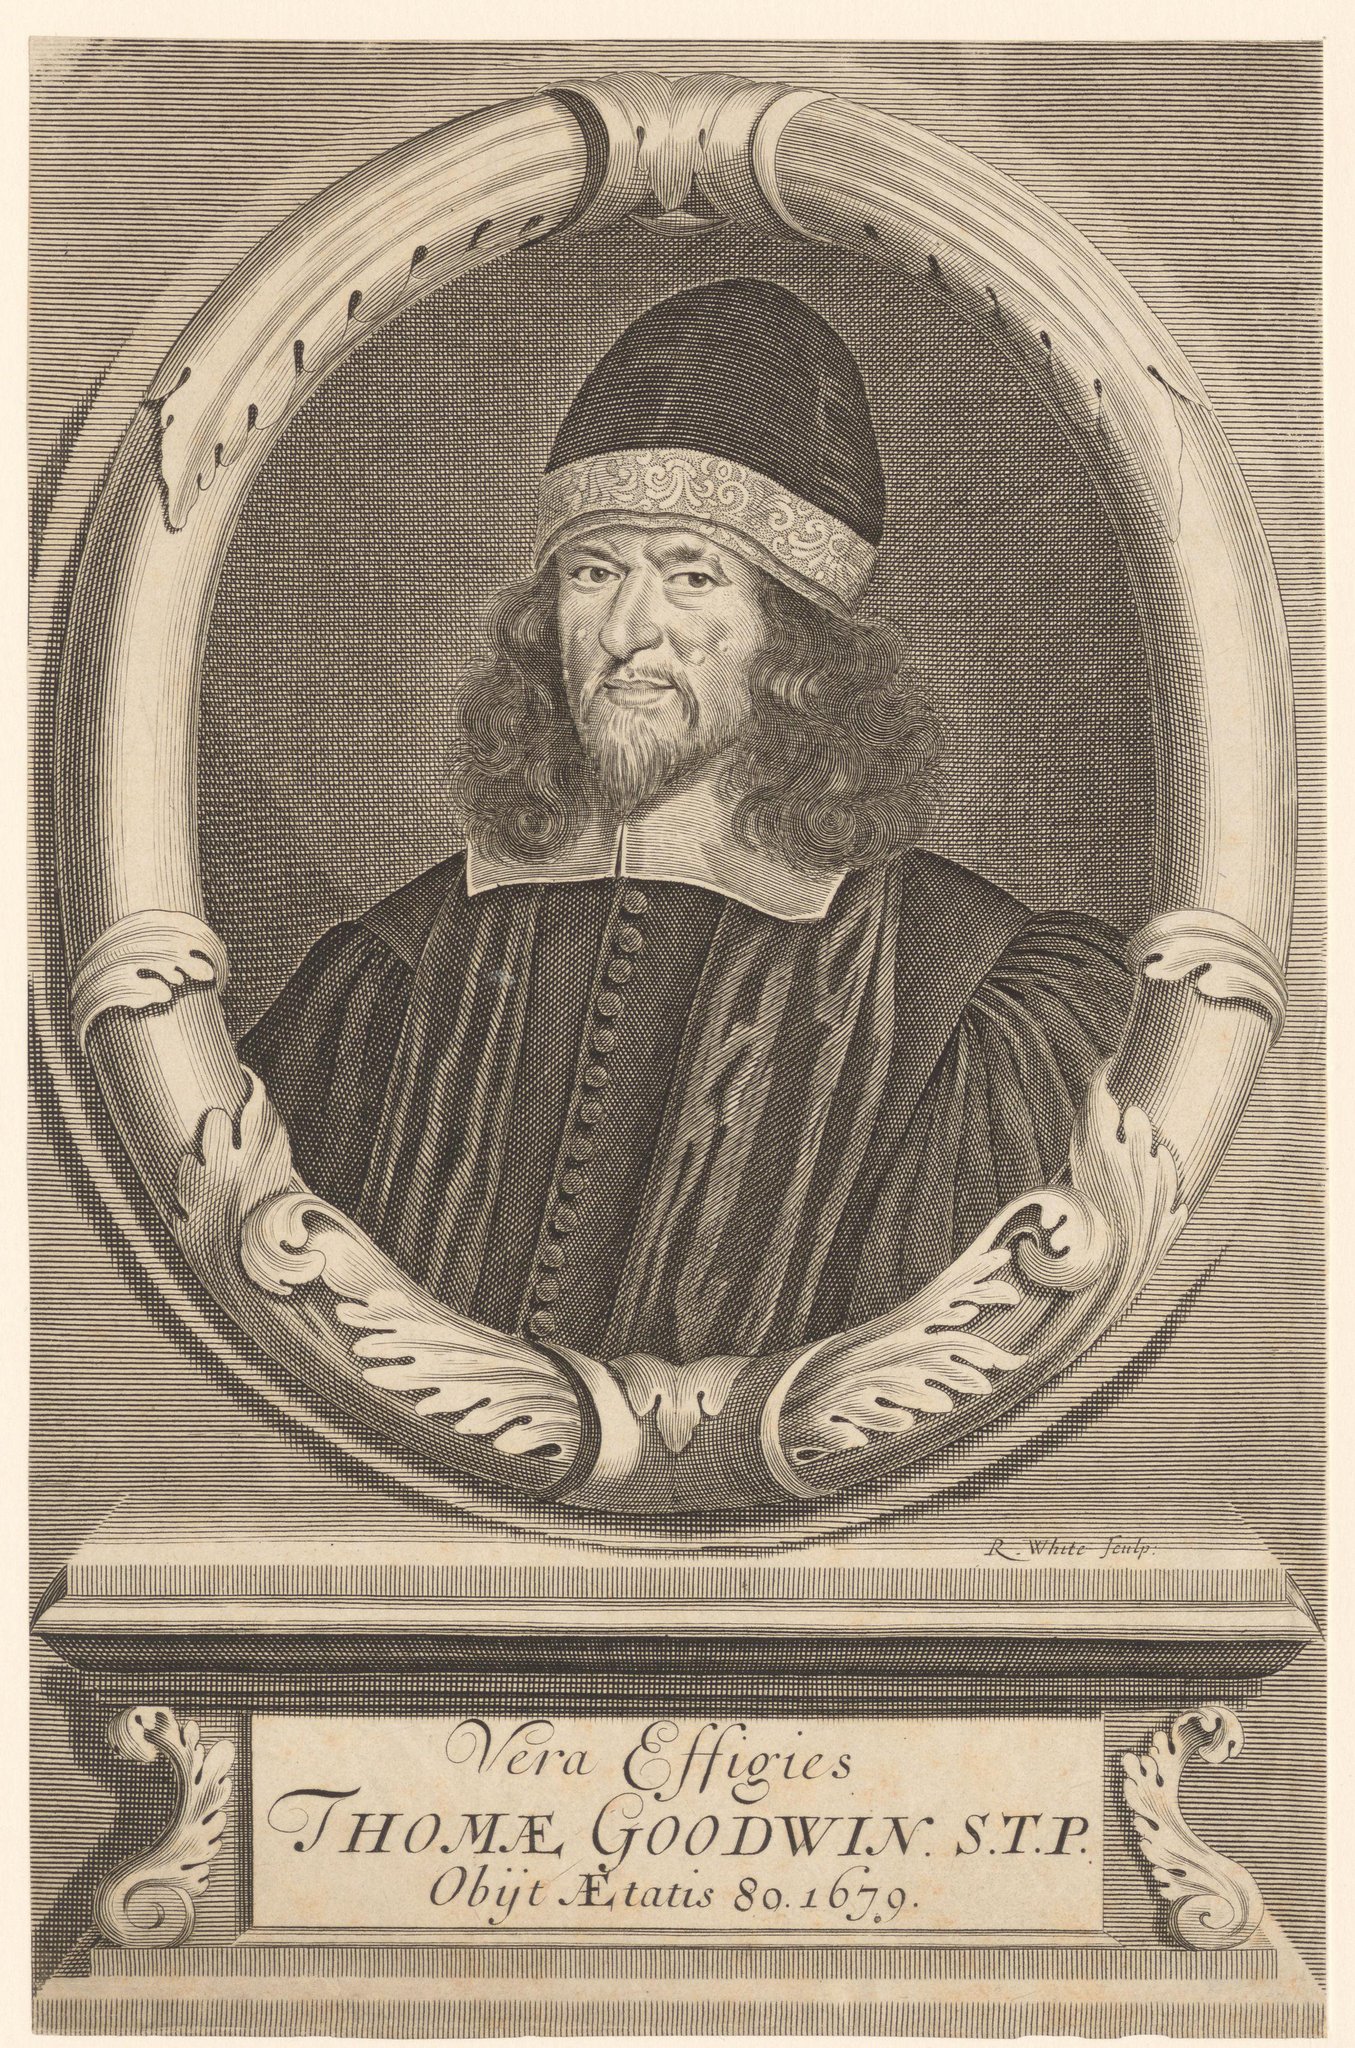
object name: book illustration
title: Portret van Thomas Goodwin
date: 1681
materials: paper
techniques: engraving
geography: london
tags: theologian, historical persons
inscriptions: collector's mark: Lugt 2228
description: Prent uit: Goodwin, Thomas. The works of Thomas Goodwin. Londen: James Nisbet, Edinburgh: James Nichol, Dublin: W. Eobeetson, 1681.